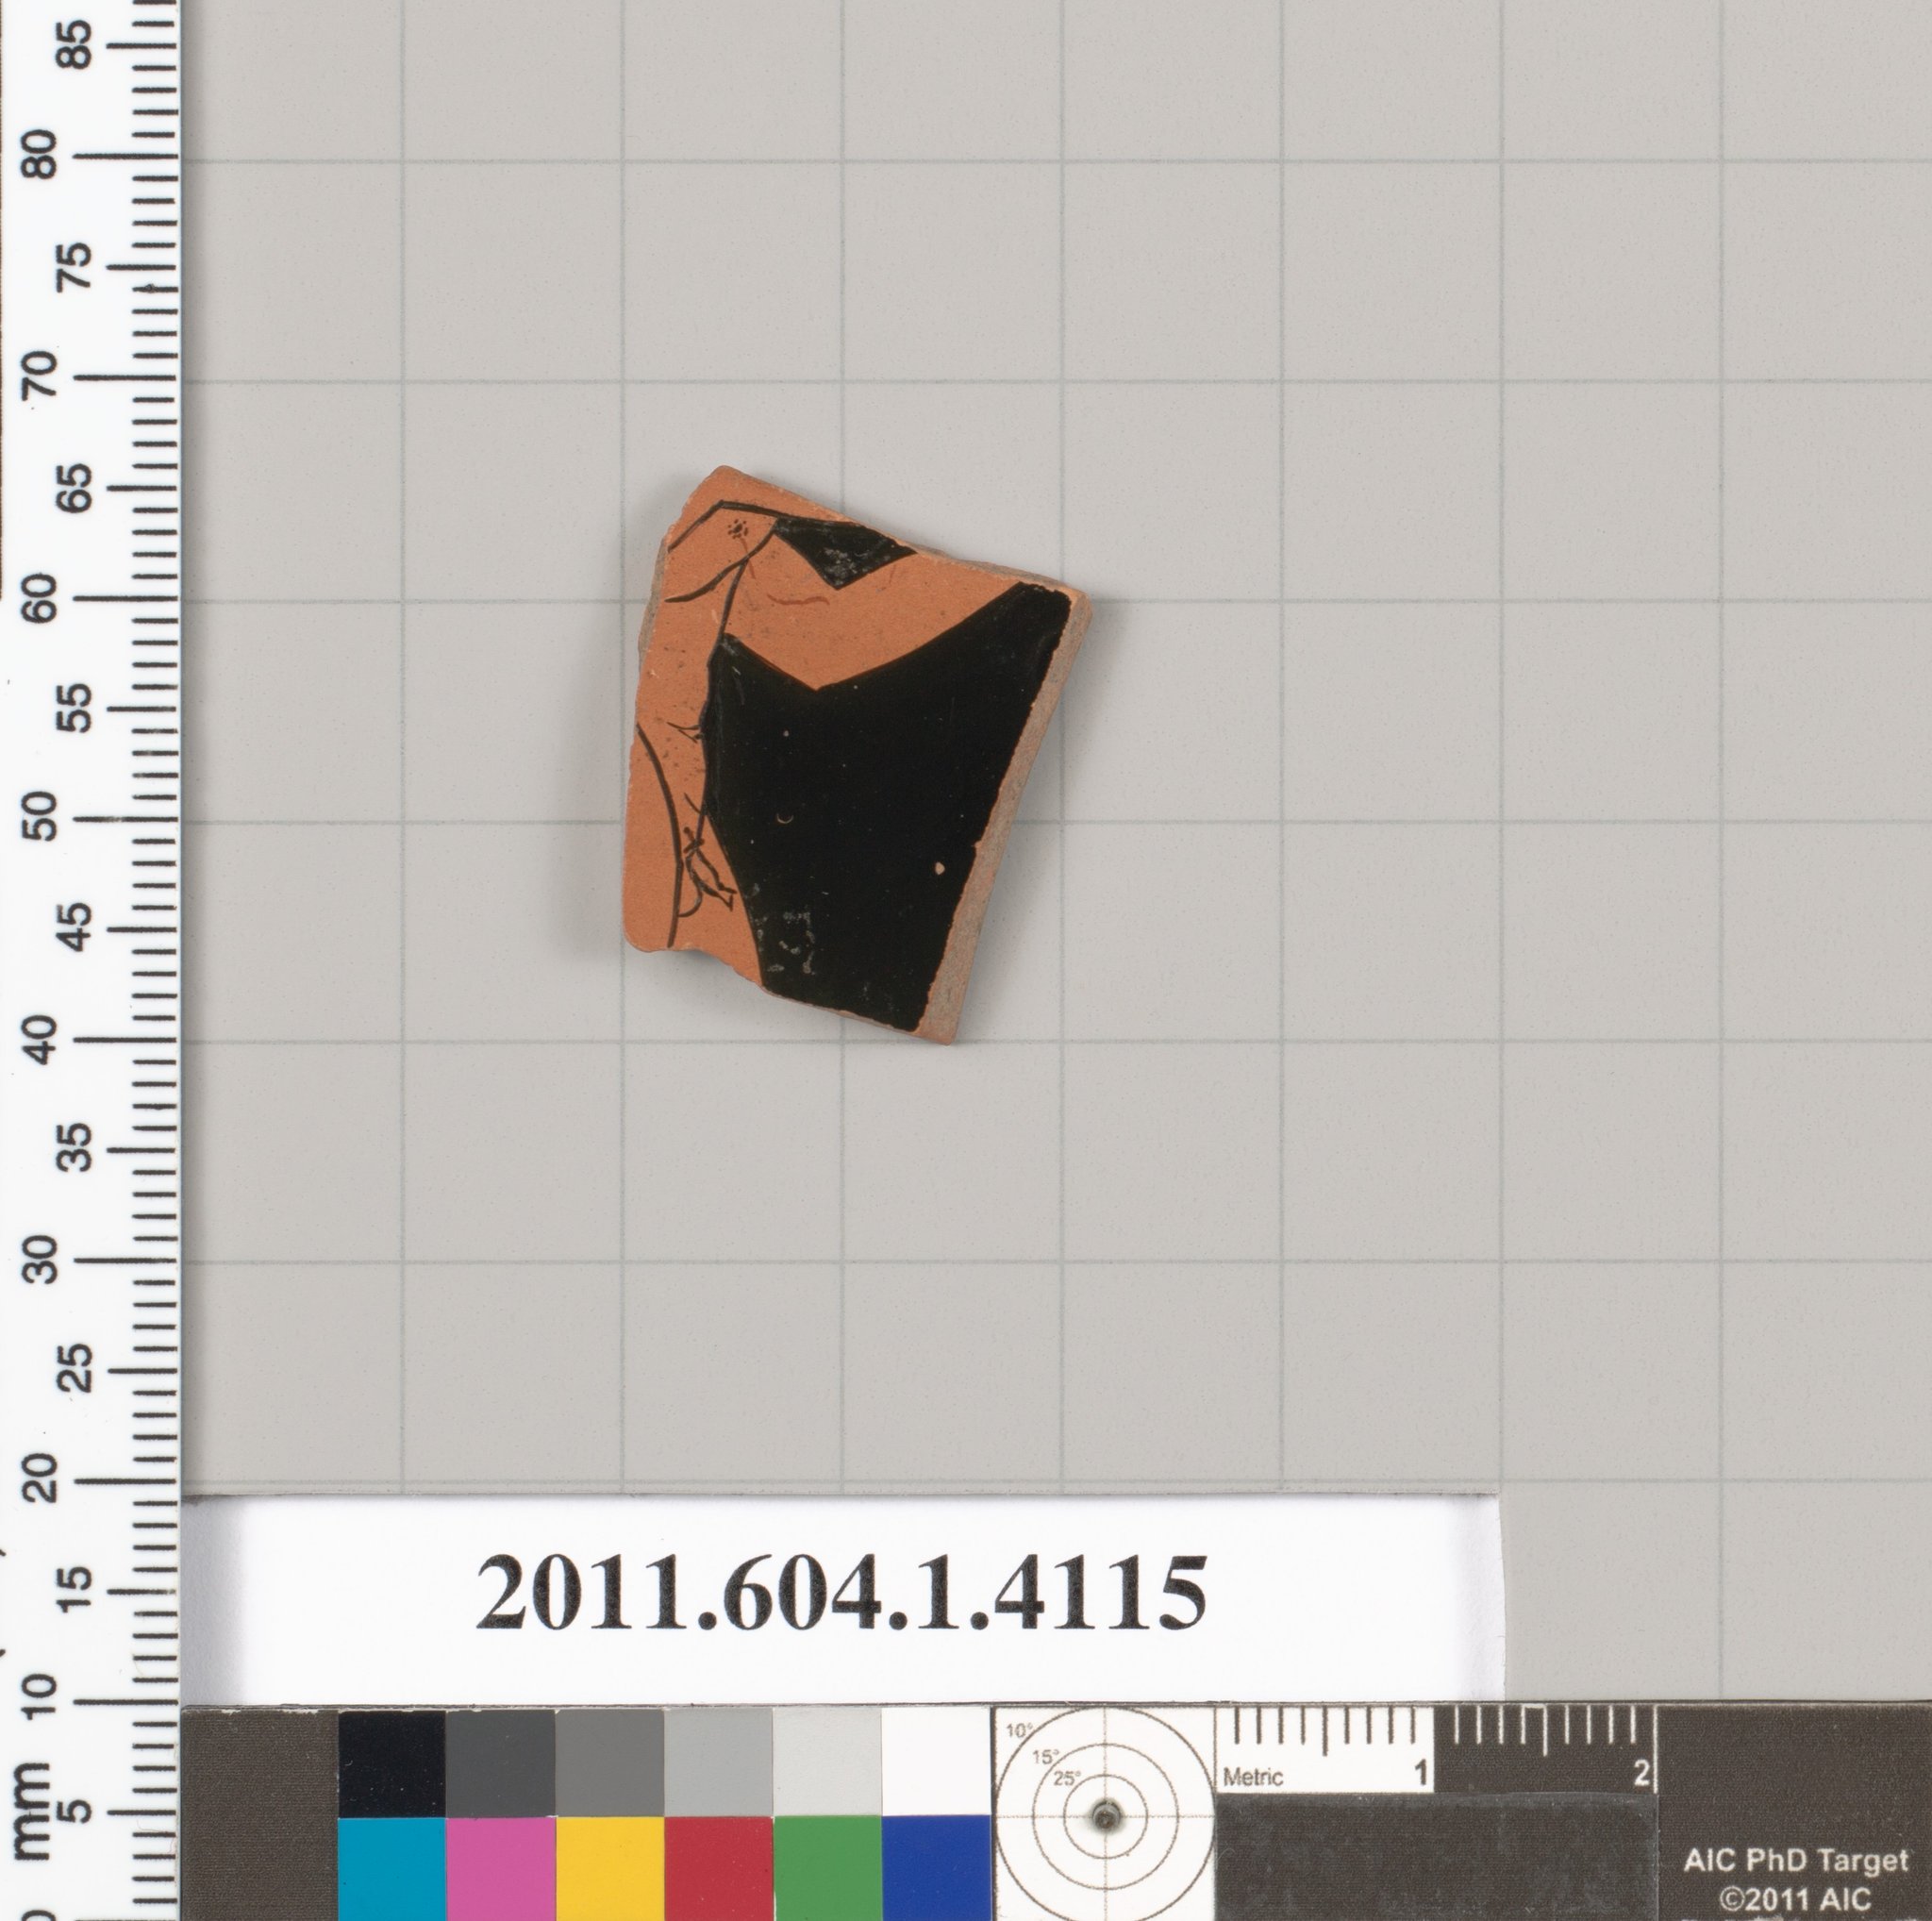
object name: kylix fragment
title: Terracotta fragment of a kylix (drinking cup)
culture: greek, attic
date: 490-470 BCE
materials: terracotta